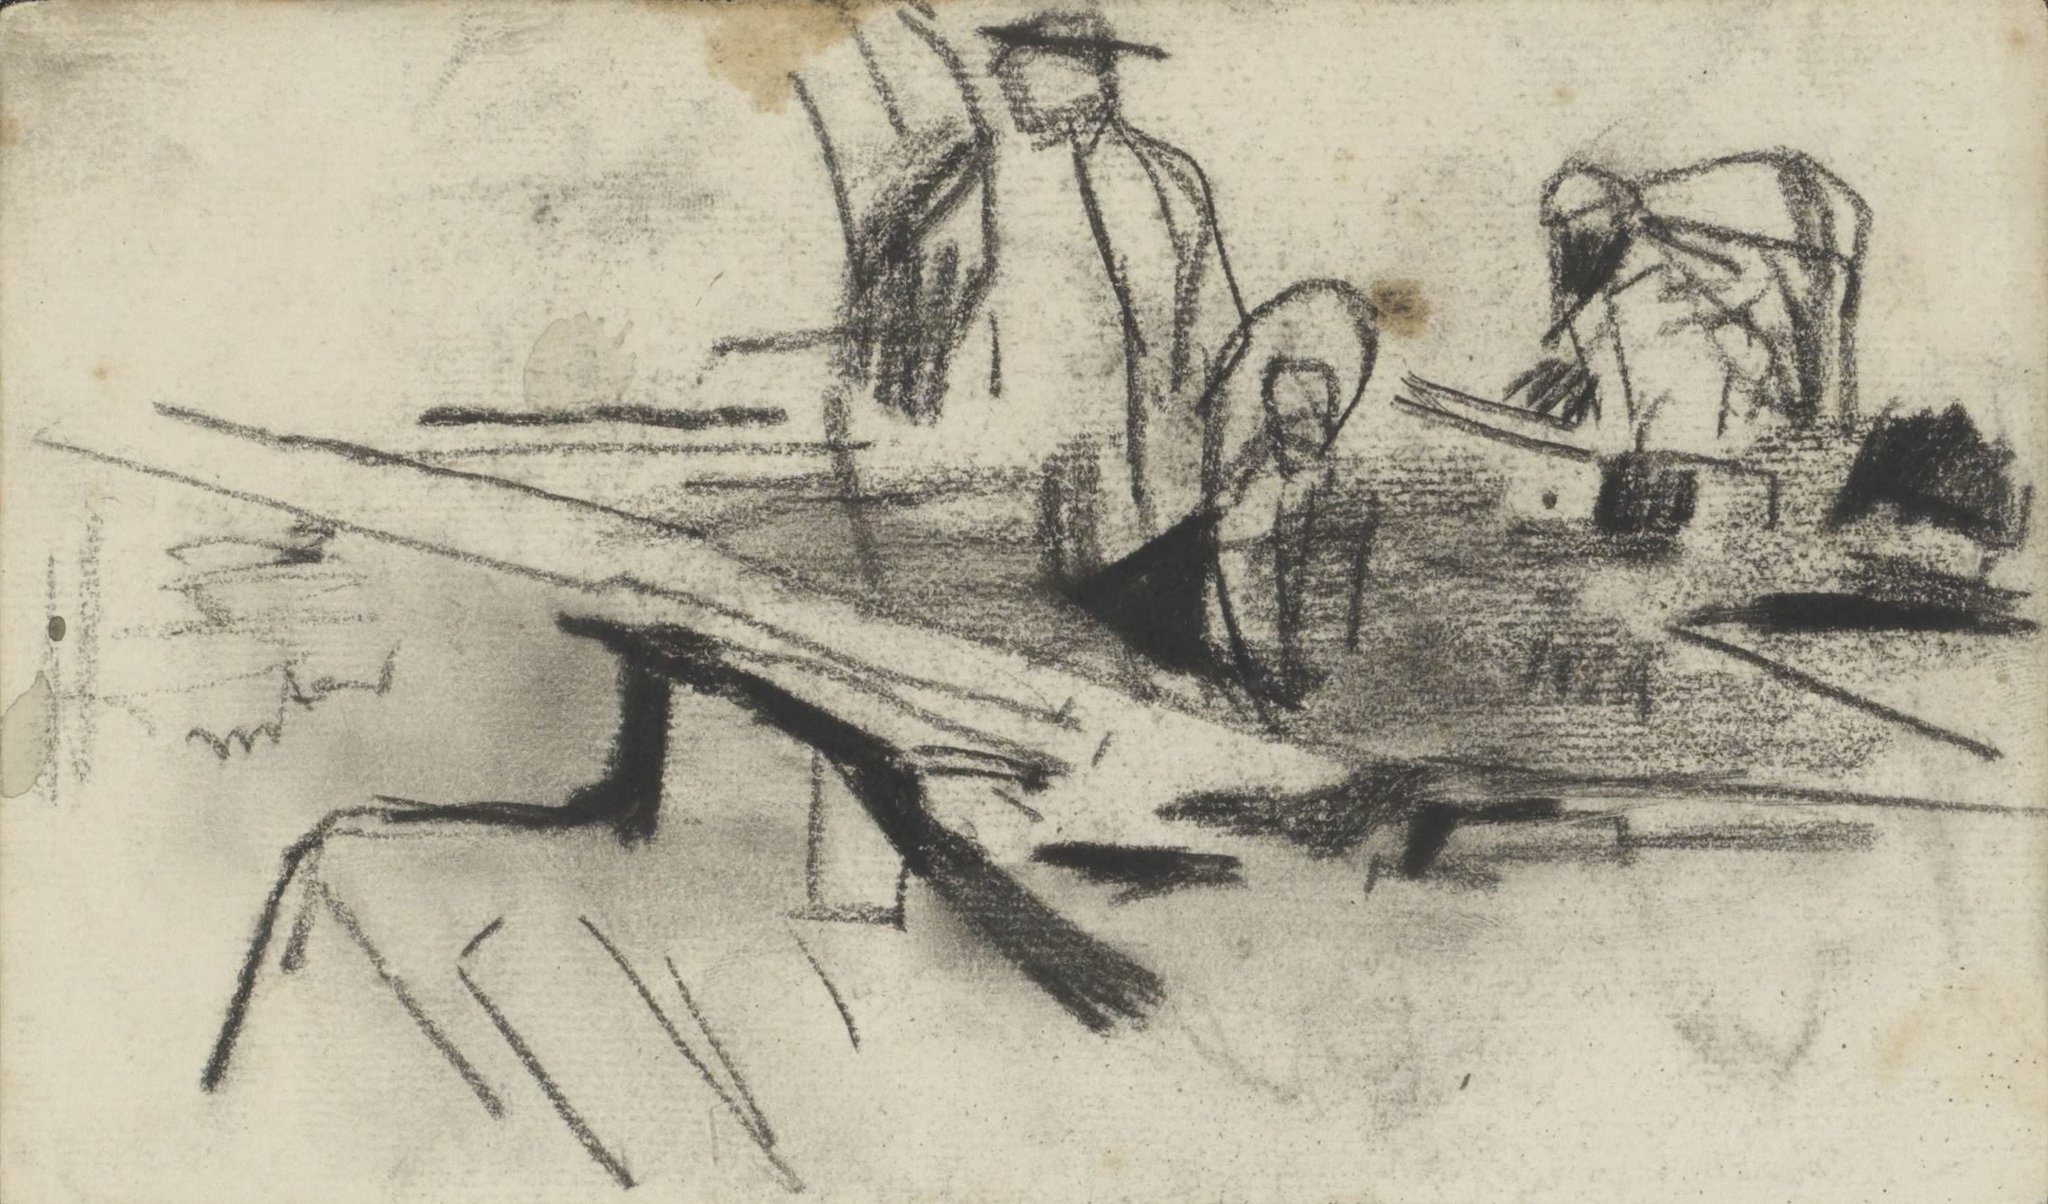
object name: drawing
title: Drie grondwerkers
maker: george hendrik breitner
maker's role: draughtsman, painter, print maker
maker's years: 1857-1923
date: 1885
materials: chalk, paper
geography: loosduinen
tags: building-site (+ men (labourers))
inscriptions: annotation: ‘water[?]’